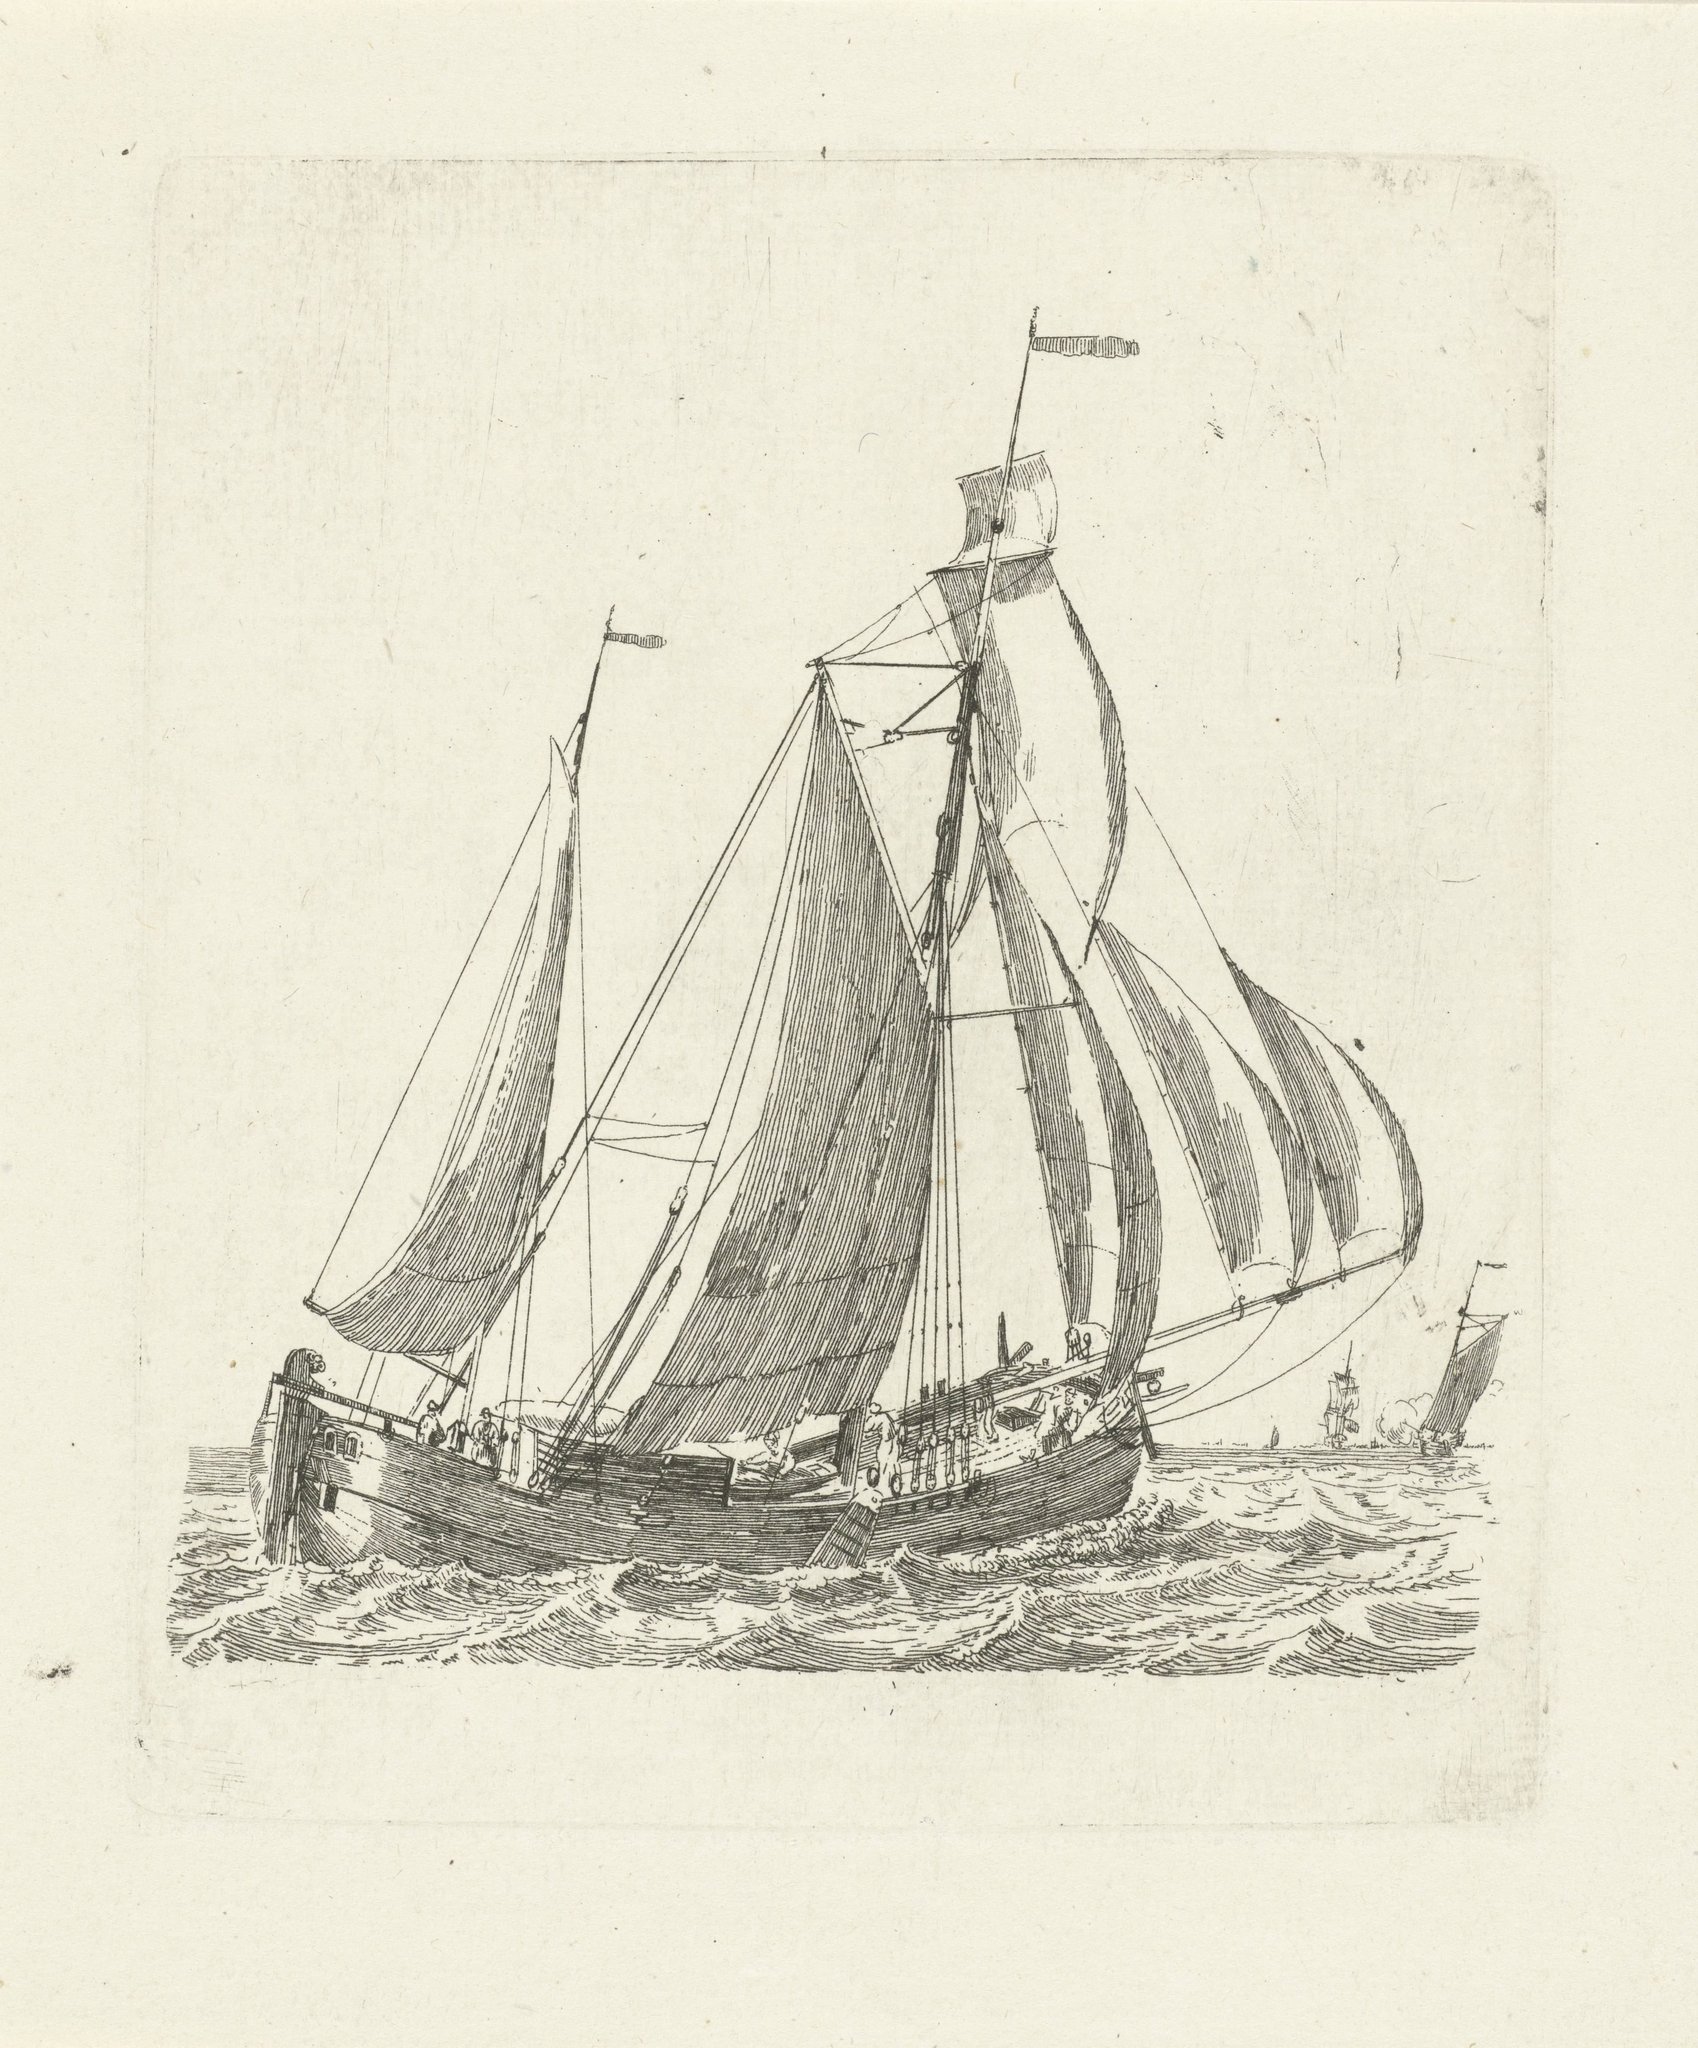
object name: print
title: Zeilschip op de golven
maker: gerrit groenewegen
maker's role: draughtsman, print maker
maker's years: 1754-1826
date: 1787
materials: paper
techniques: etching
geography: rotterdam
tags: ships (in general)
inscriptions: collector's mark: Lugt 2228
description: Zeilschip met een aantal figuren op de golven. Rechts op de achtergrond zijn drie andere zeilschepen te zien. Deze prent is deel van een serie van twaalf prenten met boten.